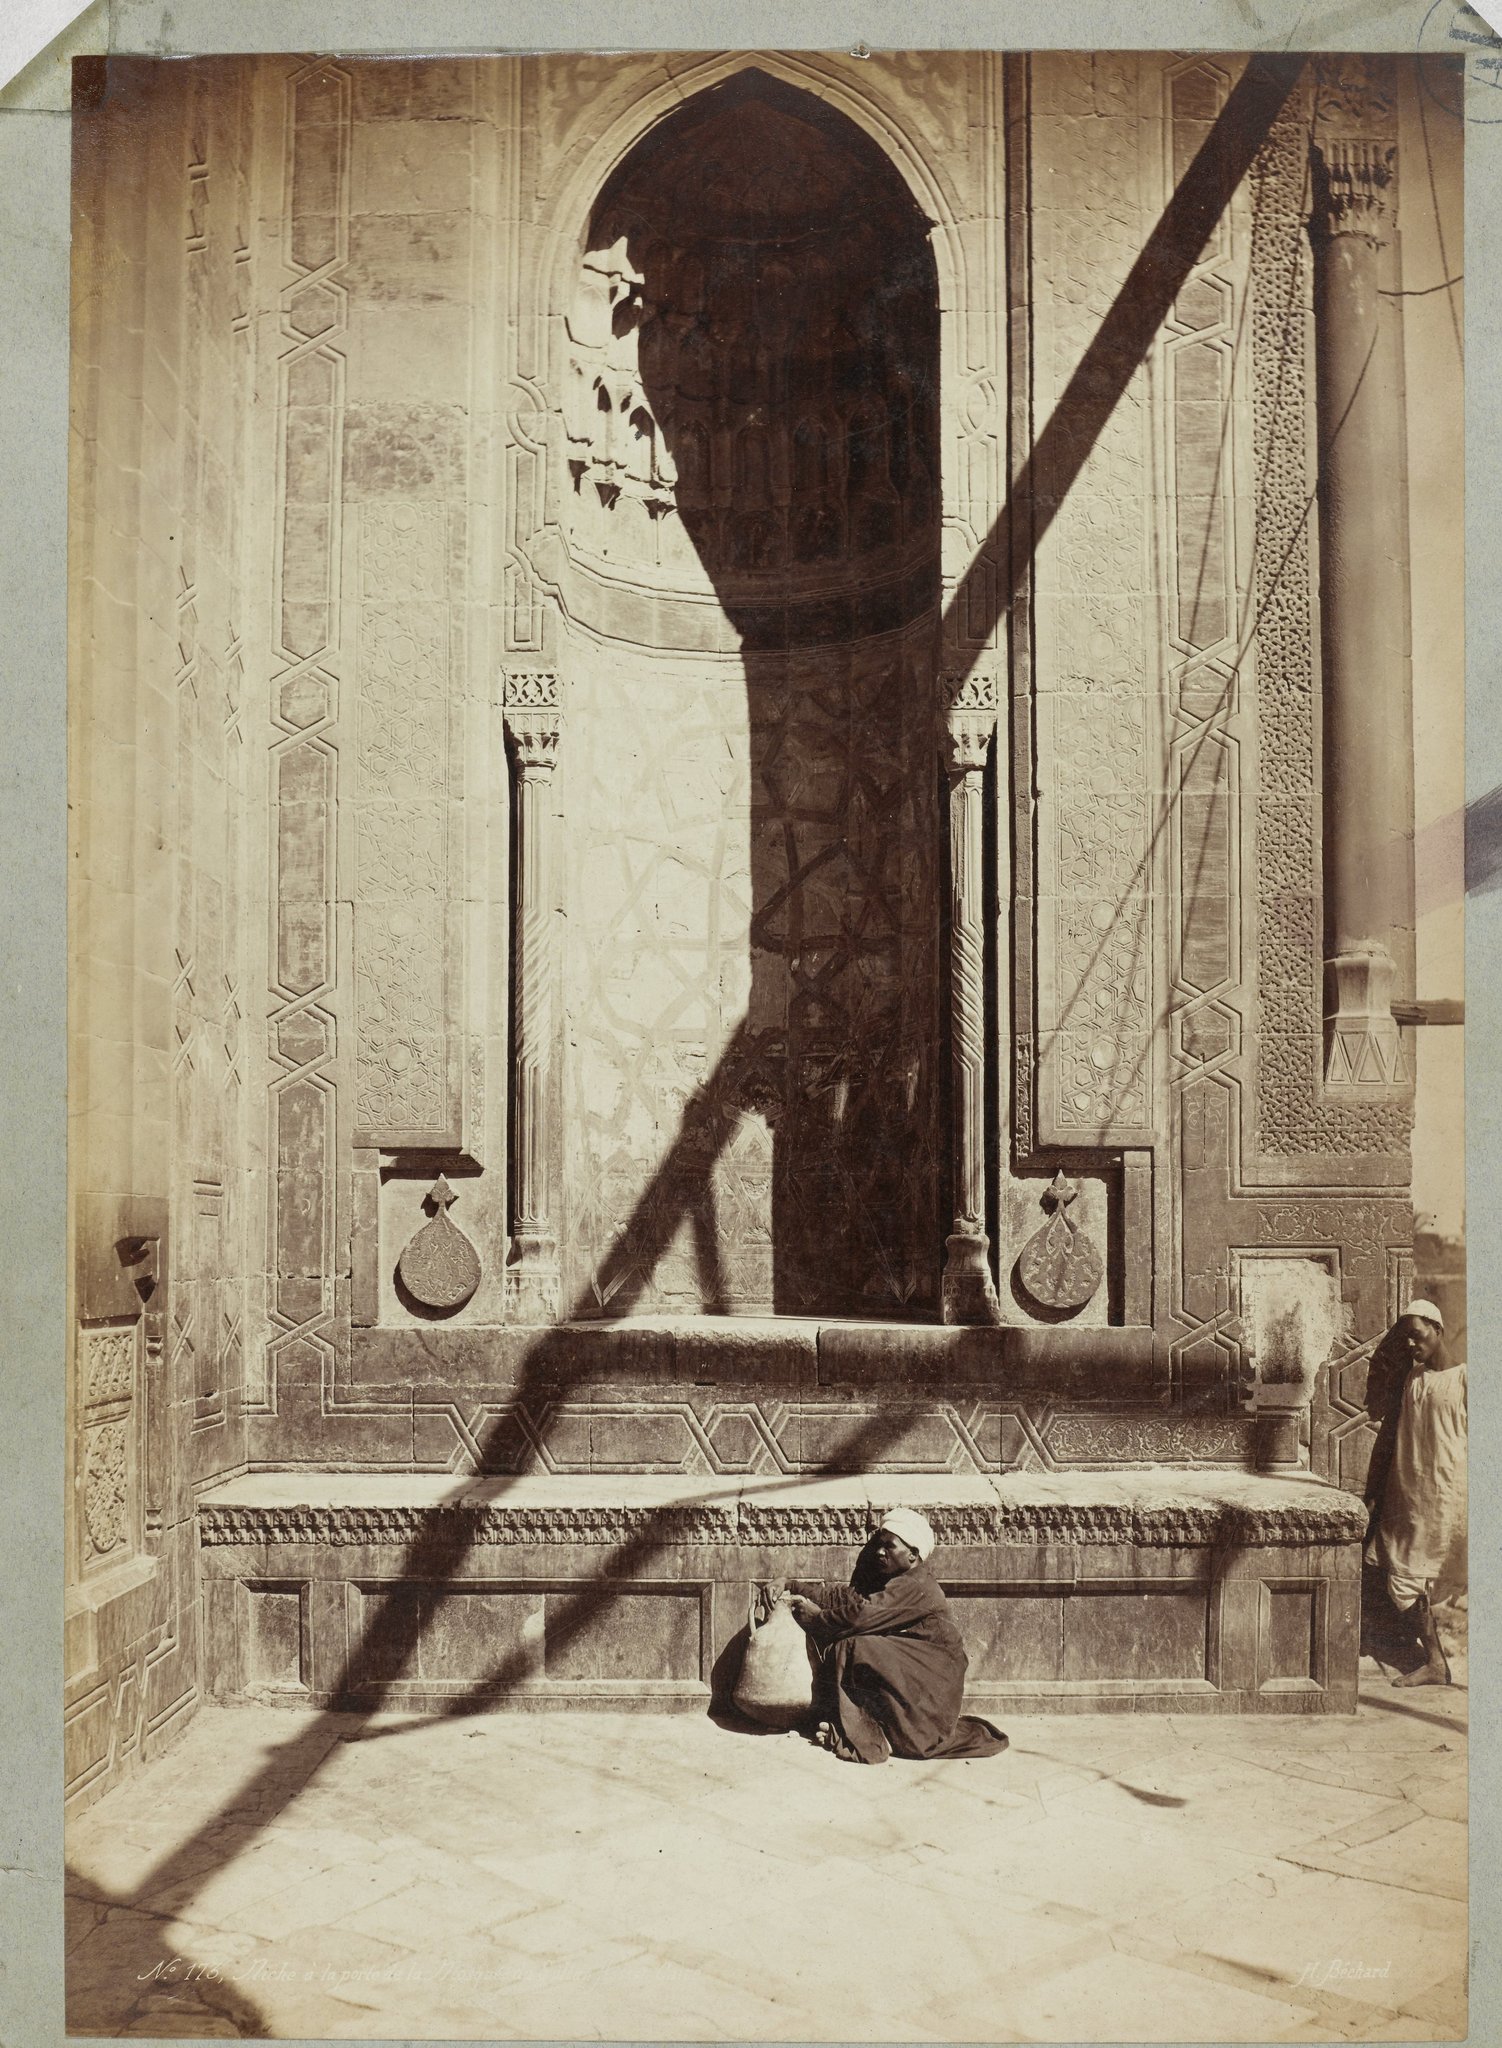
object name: photograph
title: Niche à la porte de la Mosque du Sultan Hassan, Caire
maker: henri béchard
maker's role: fotograaf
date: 1869-1889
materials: cardboard, paper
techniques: albumen print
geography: cairo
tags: temple, shrine ~ islam, mohammedanism, mosque-madrasa of sultan hassan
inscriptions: inscription: ‘AP’, number: ‘No. 176’